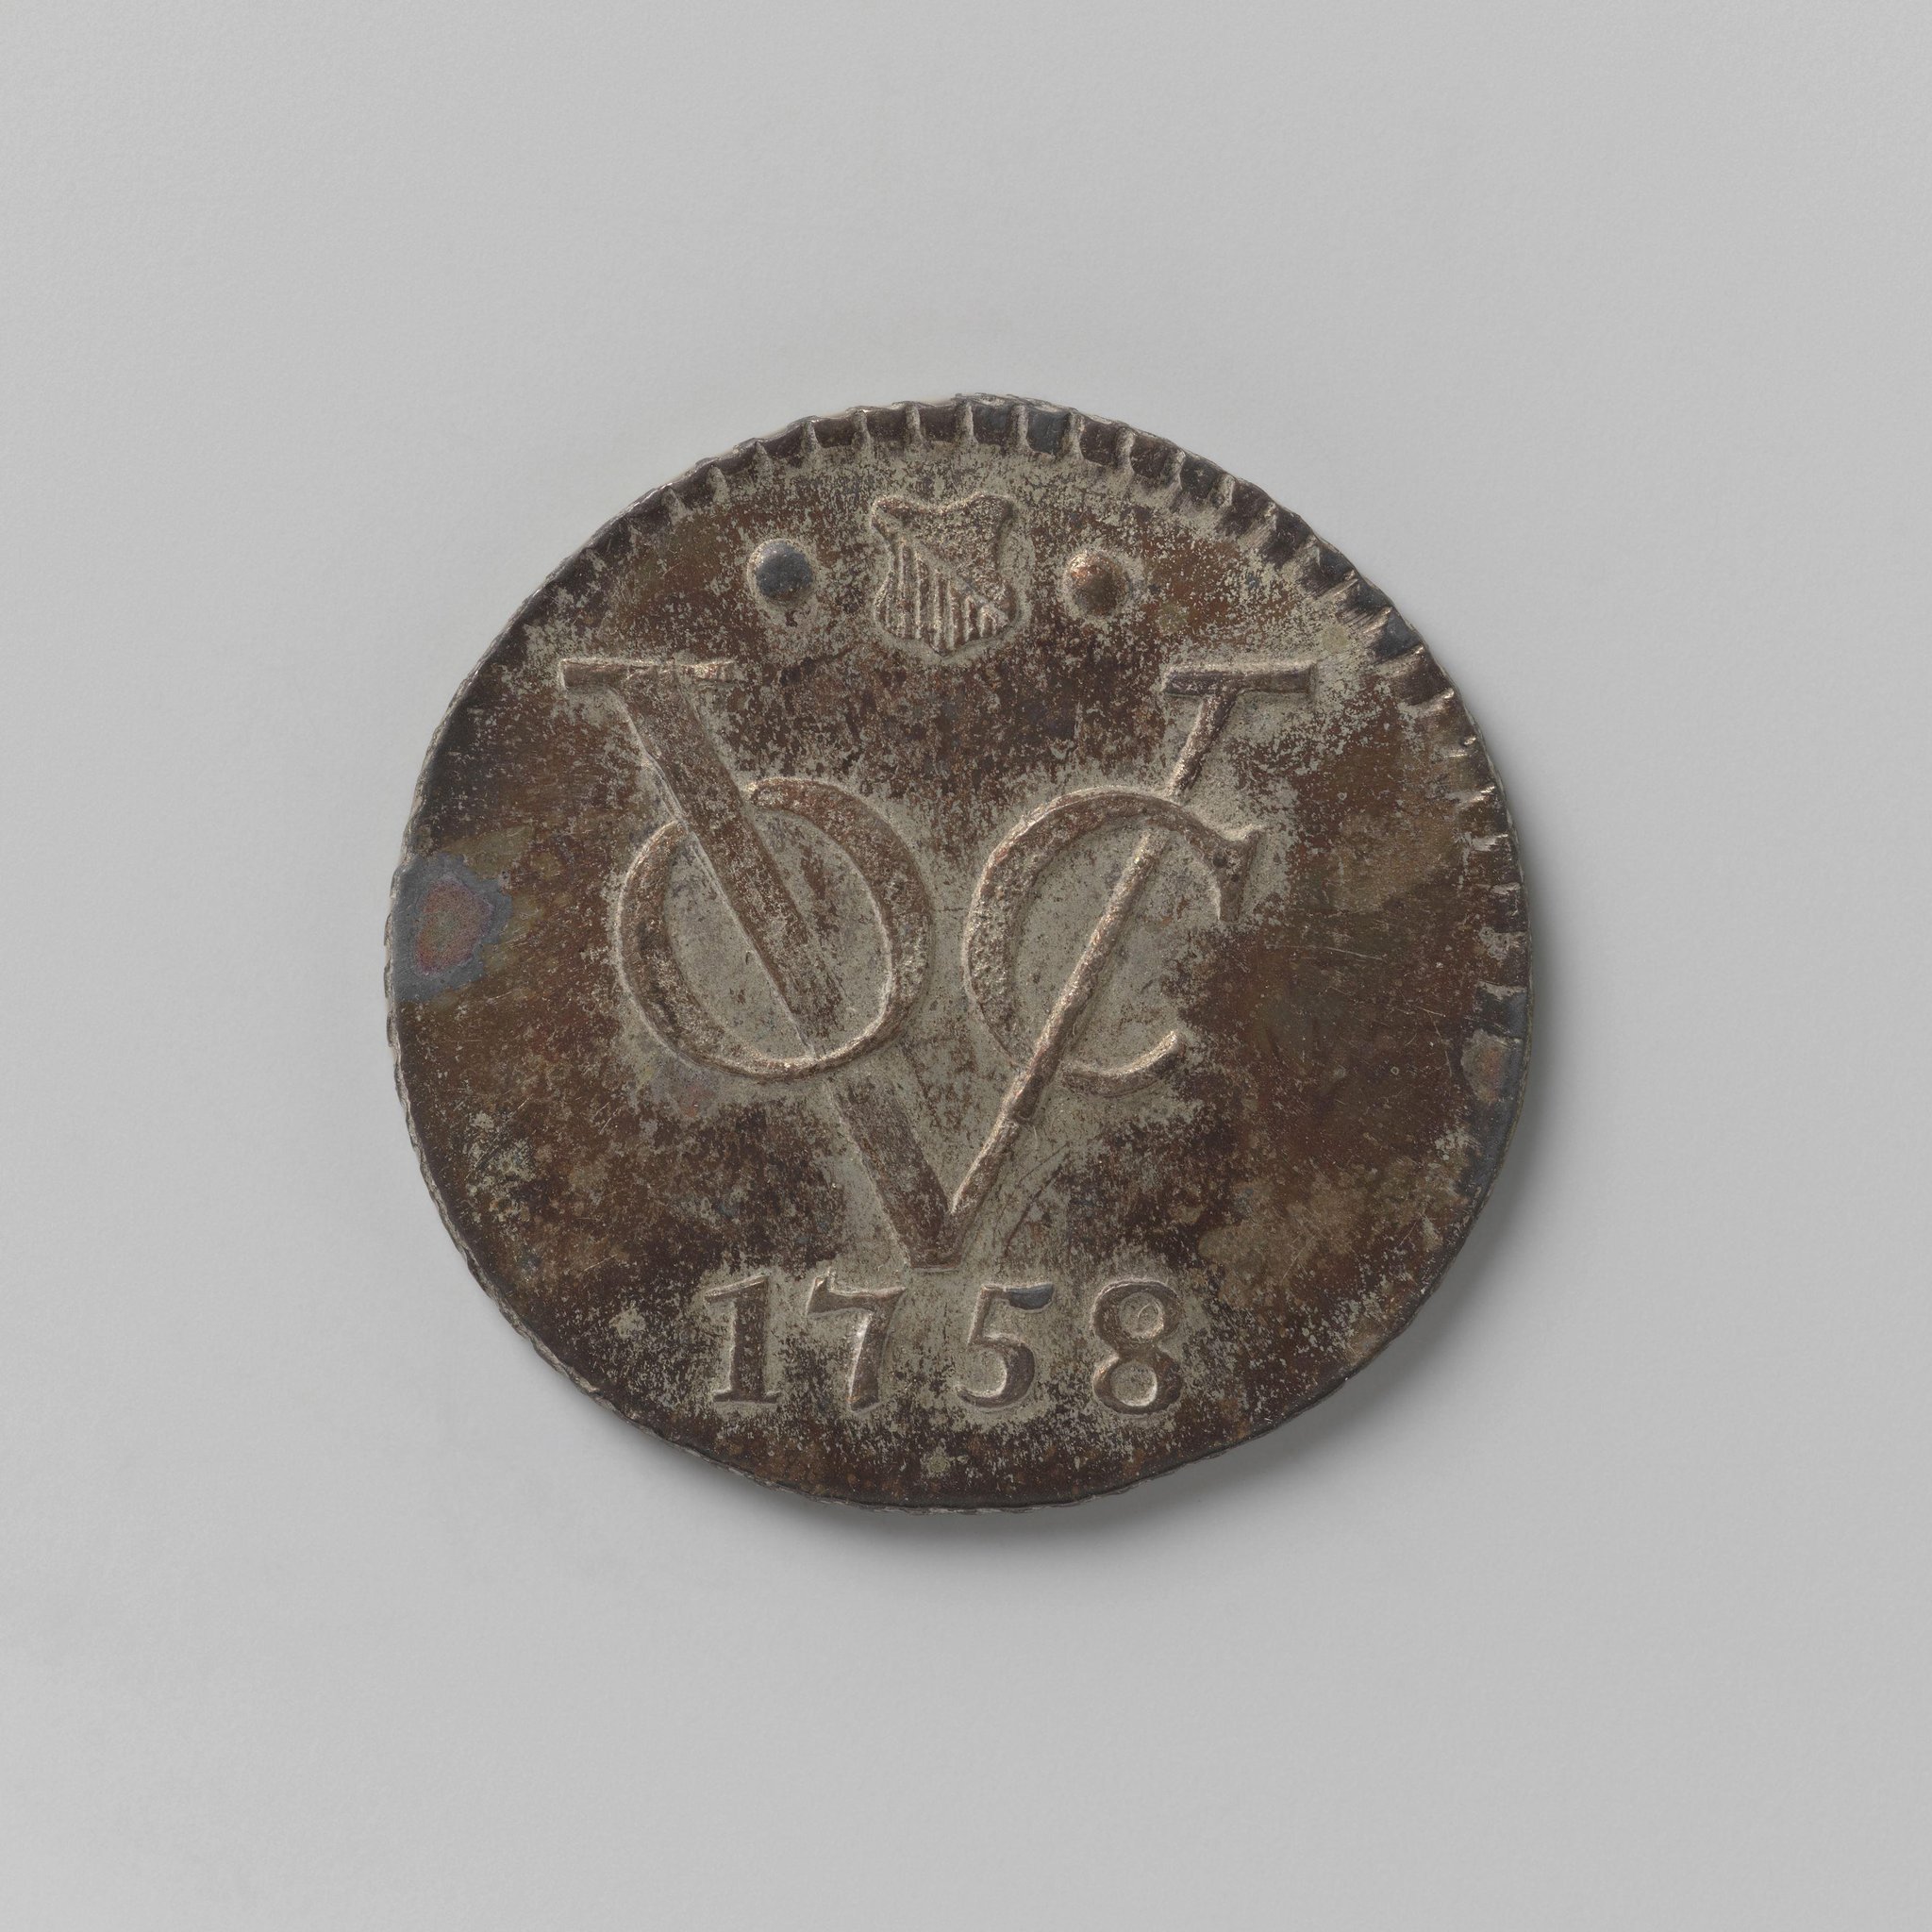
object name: coin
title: VOC, ½ duit stad Utrecht,1758. Afslag in zilver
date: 1758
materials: silver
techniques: striking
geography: utrecht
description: Zilveren munt. Voorzijde: gekroond ingebogen wapenschild van de stad Utrecht. Keerzijde: monogram van de VOC, waarboven muntteken en waaronder jaartal. Kabelrand.